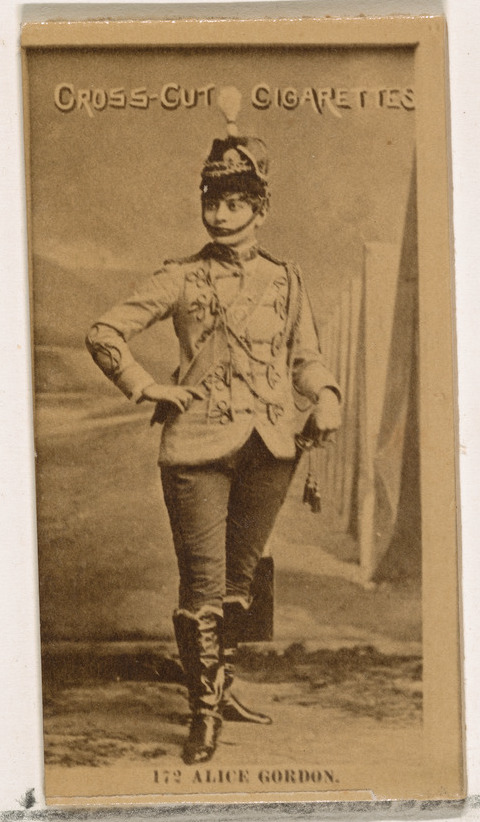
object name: print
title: Card Number 172, Alice Gordon, from the Actors and Actresses series (N145-2) issued by Duke Sons & Co. to promote Cross Cut Cigarettes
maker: w. duke, sons & co.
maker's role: publisher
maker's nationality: american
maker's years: 1870-1920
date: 1880-1889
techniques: albumen silver print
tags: portraits,women,actresses